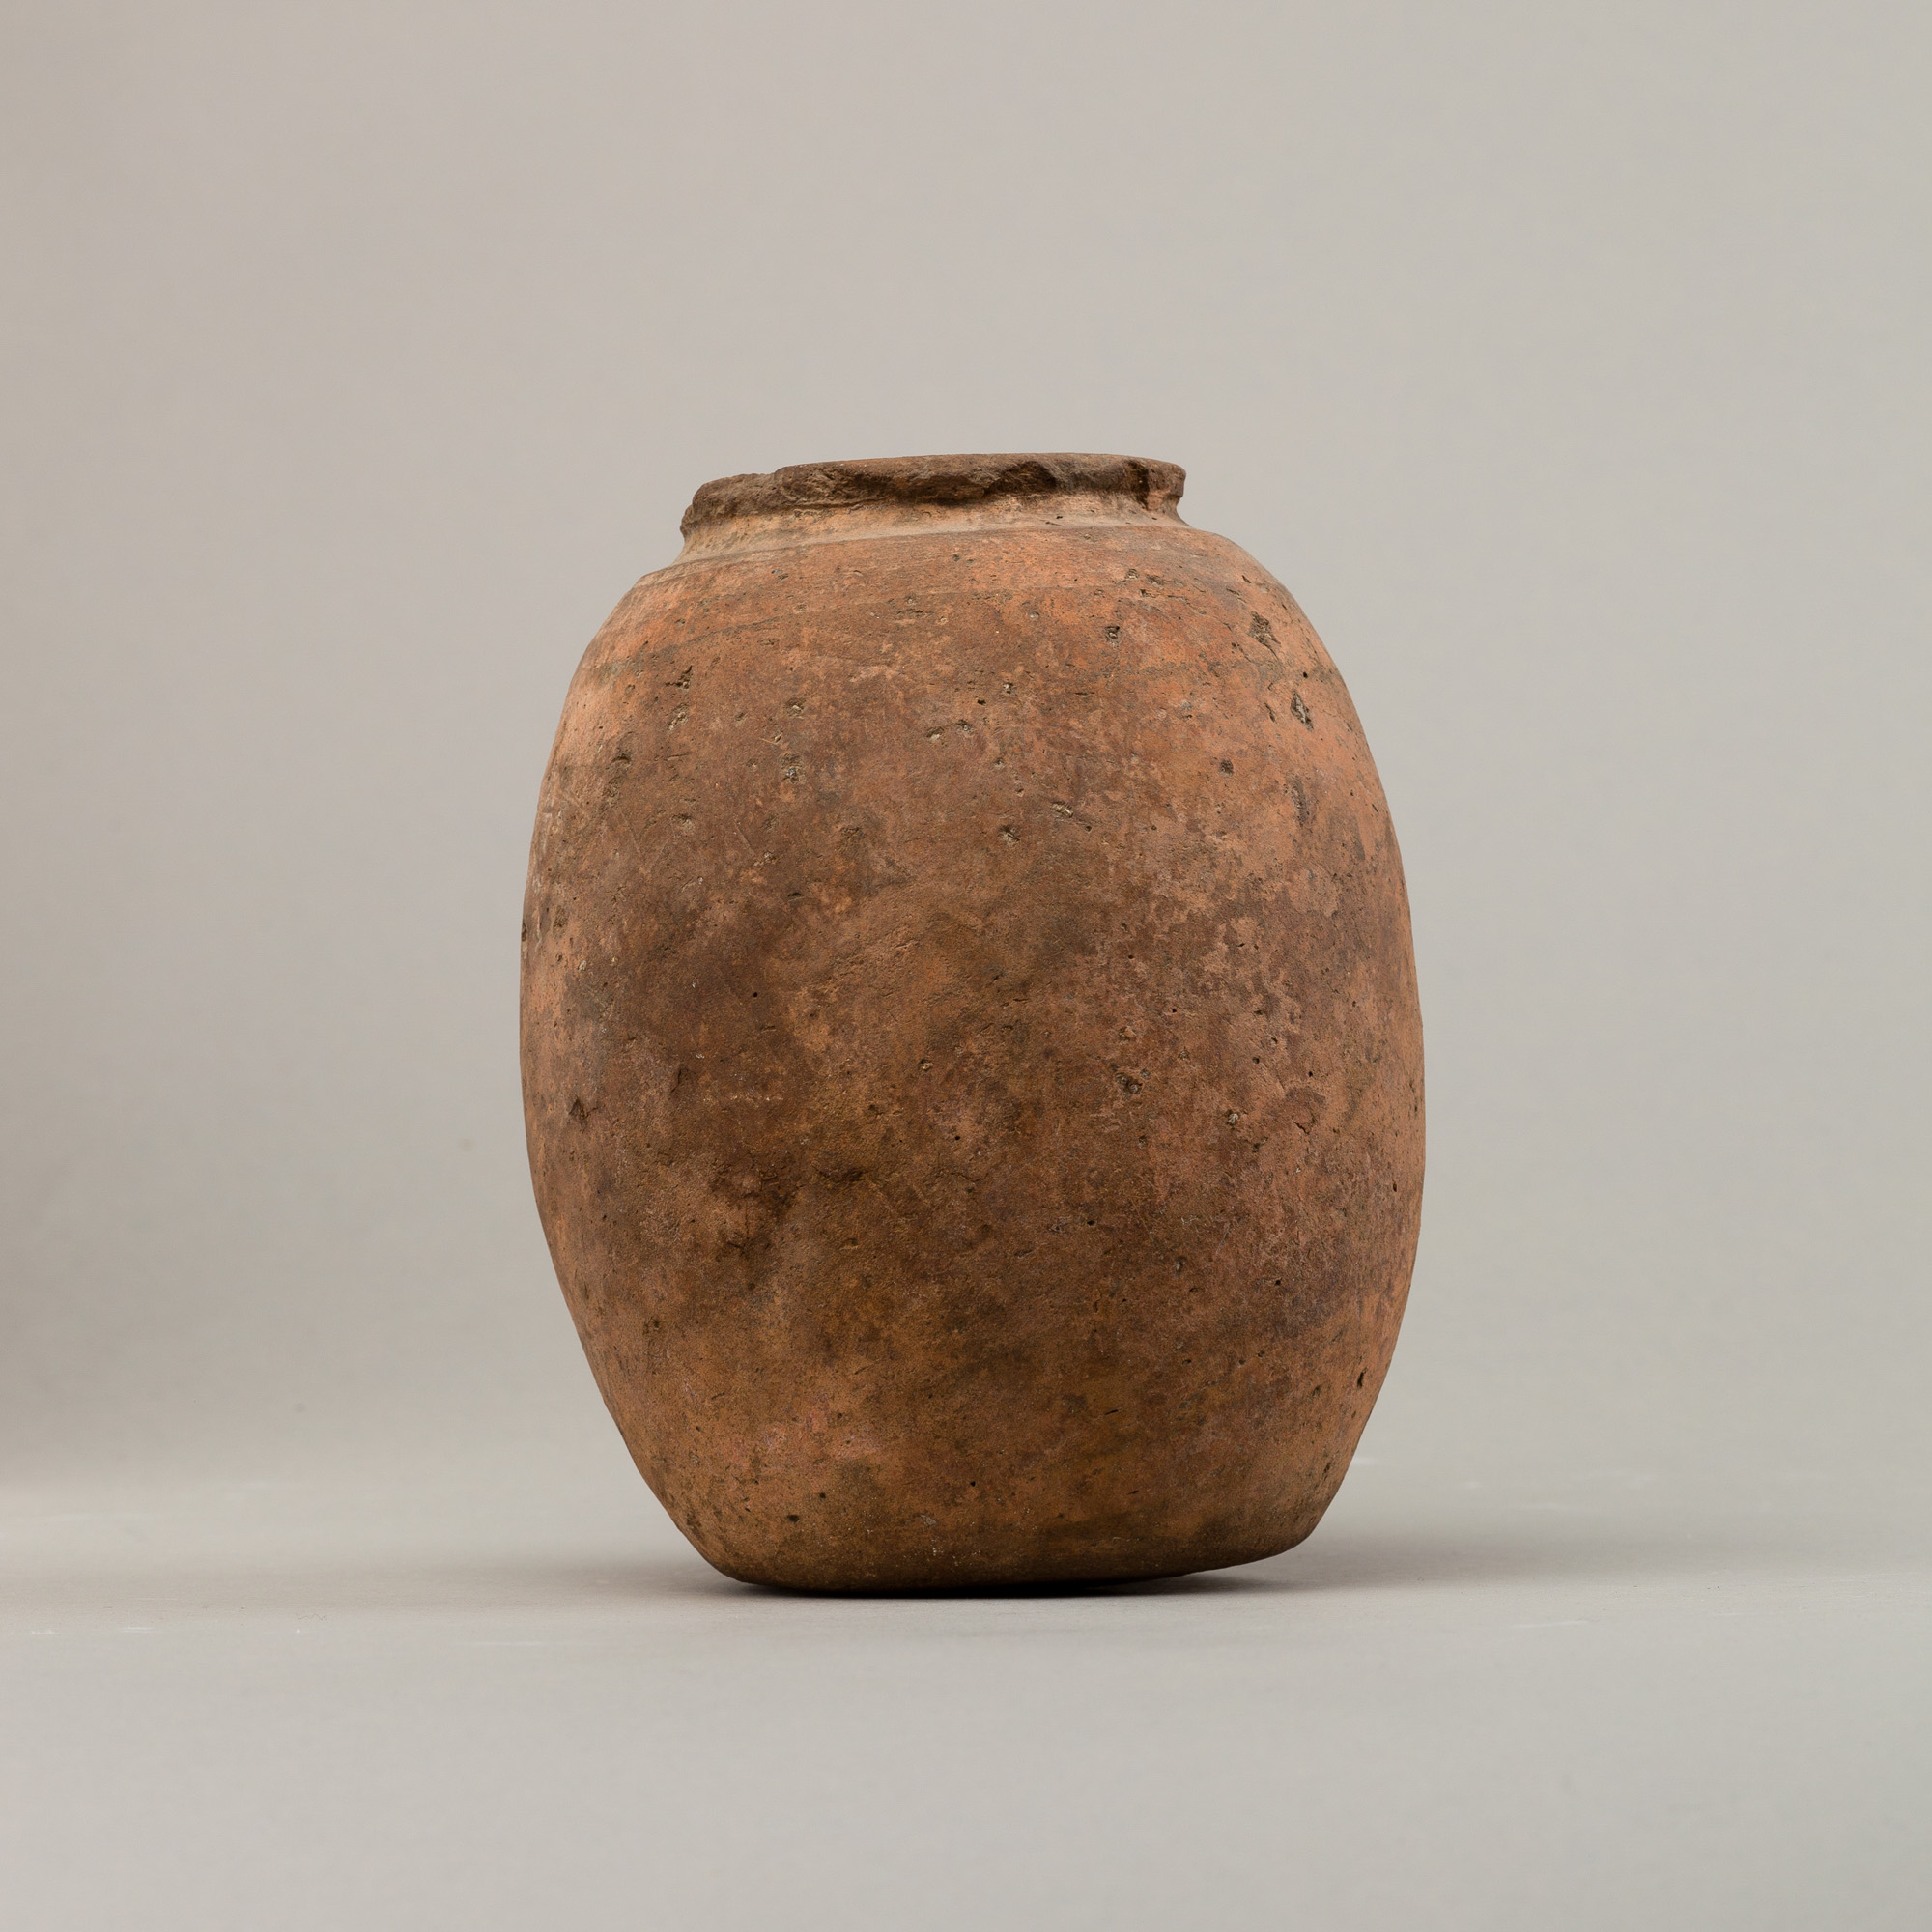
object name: jar, ovoid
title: Ovoid jar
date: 3100-2649 BCE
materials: pottery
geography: egypt